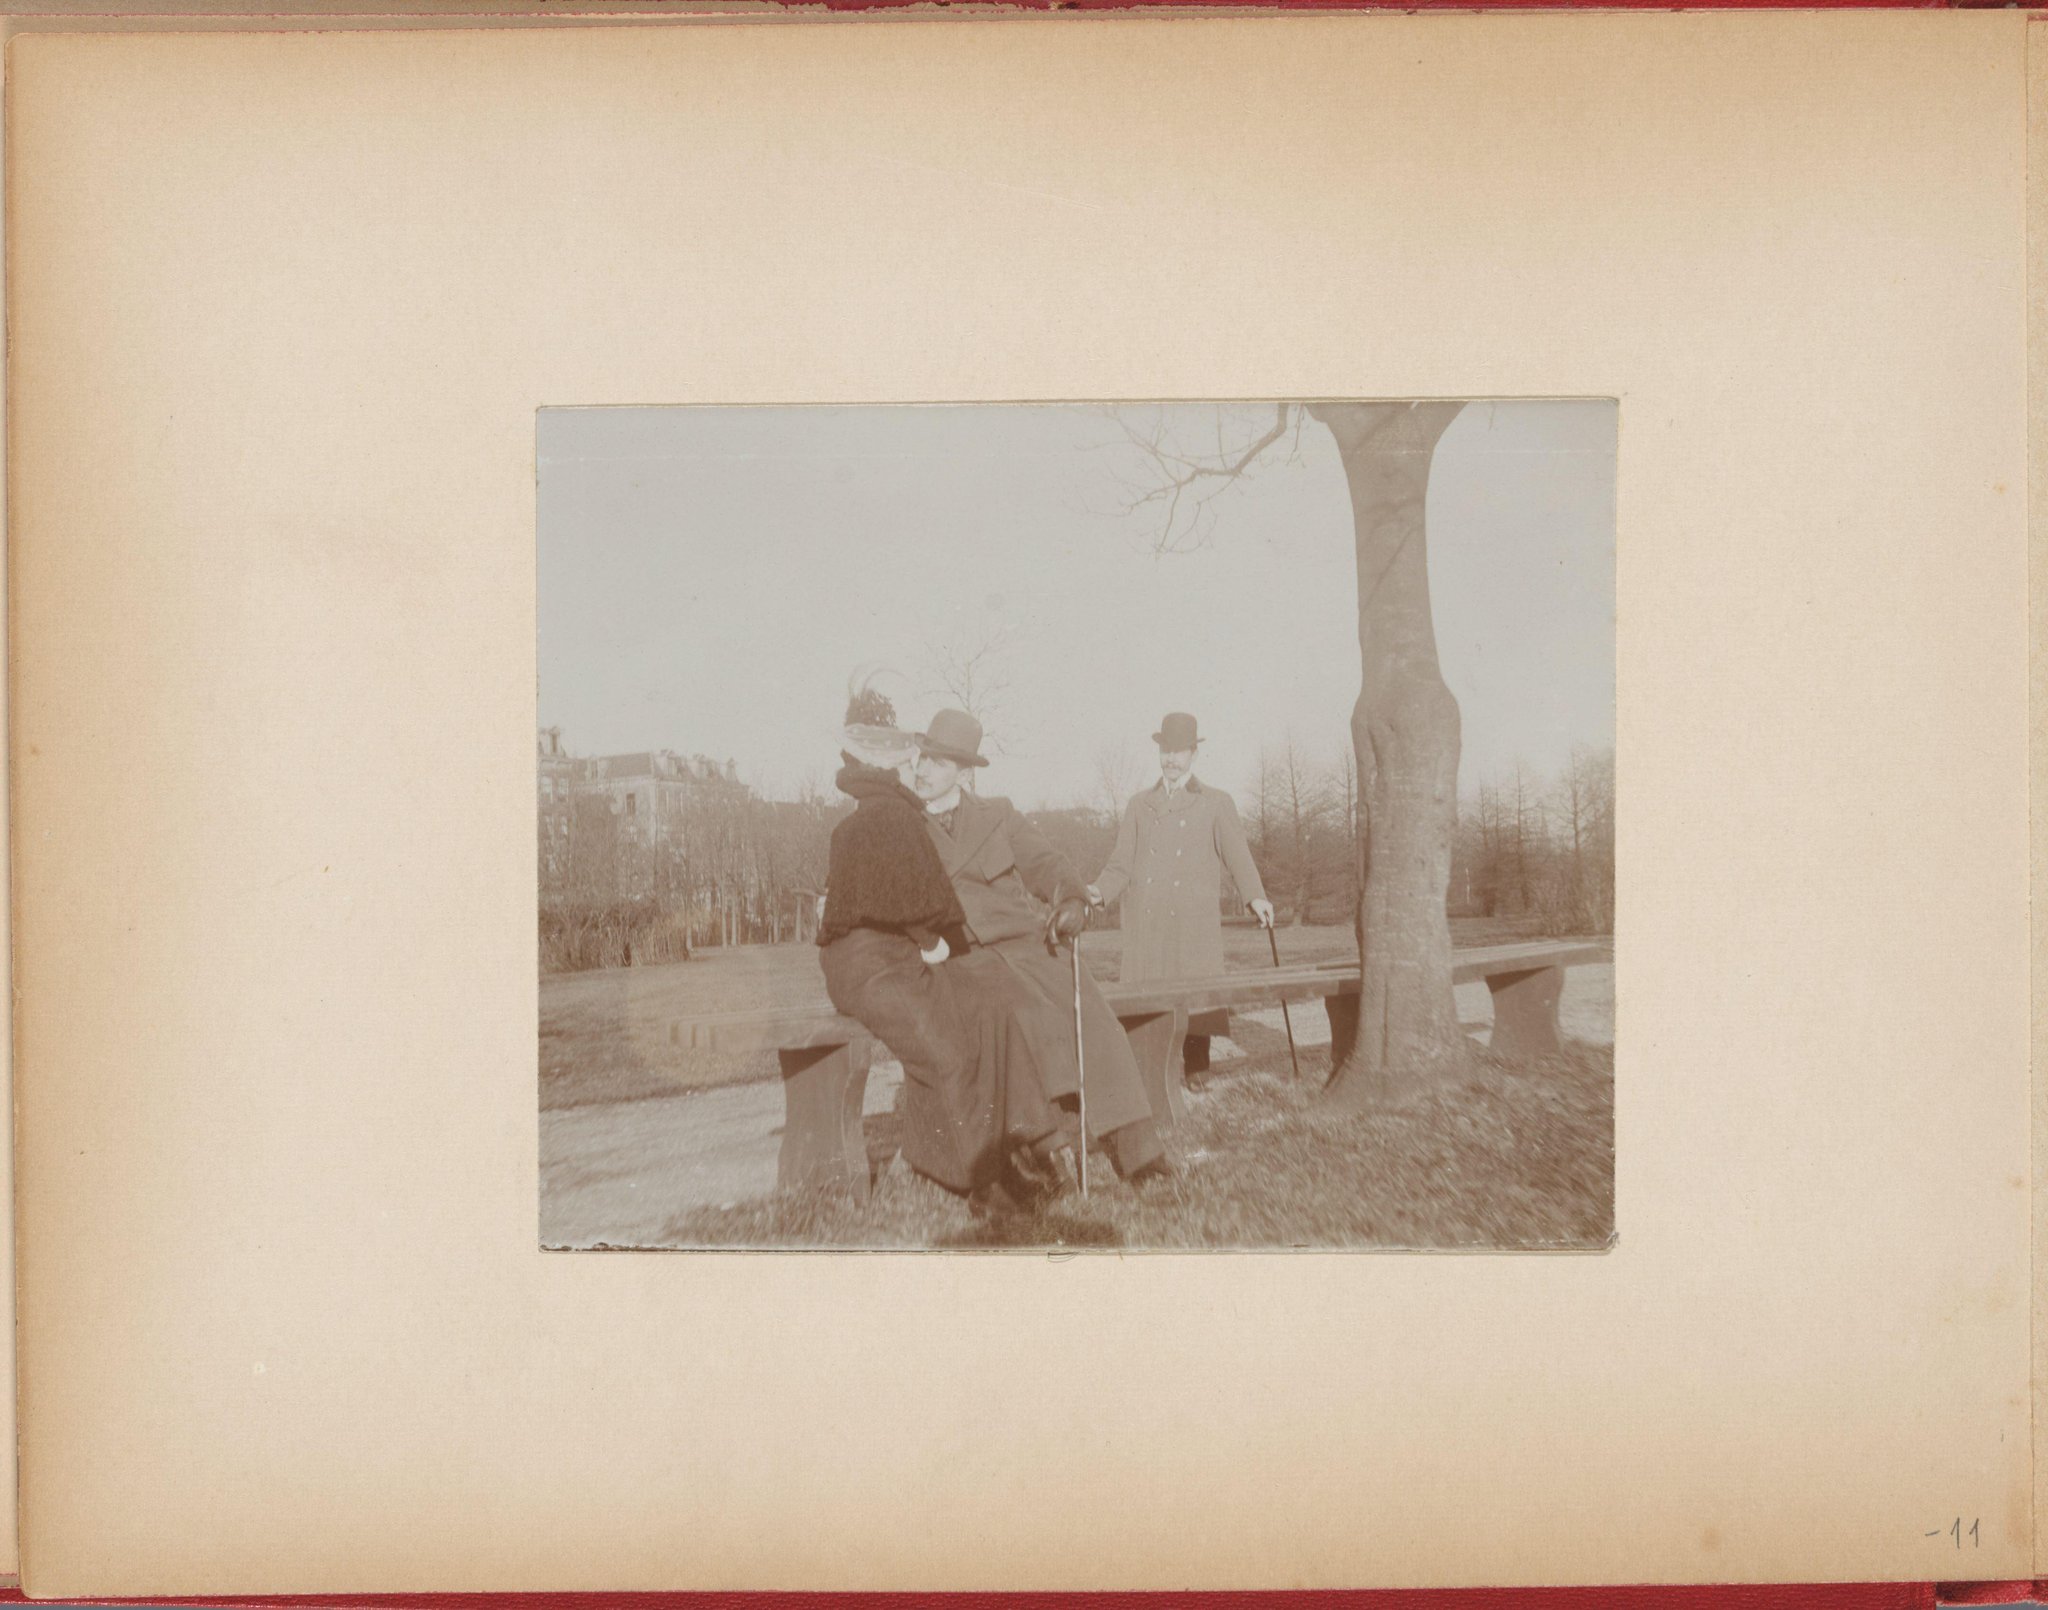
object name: photograph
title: Jong stel, de vrouw met hoed met veren, wordt gekust op een bankje in een park, door de man die haar begluurde, de andere man nadert , fotoverhaal 3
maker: gerard aalbersberg (us)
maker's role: amateurfotograaf, arts, chirurg, gynaecoloog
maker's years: 1870-1934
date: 1899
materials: paper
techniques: photography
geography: amsterdam